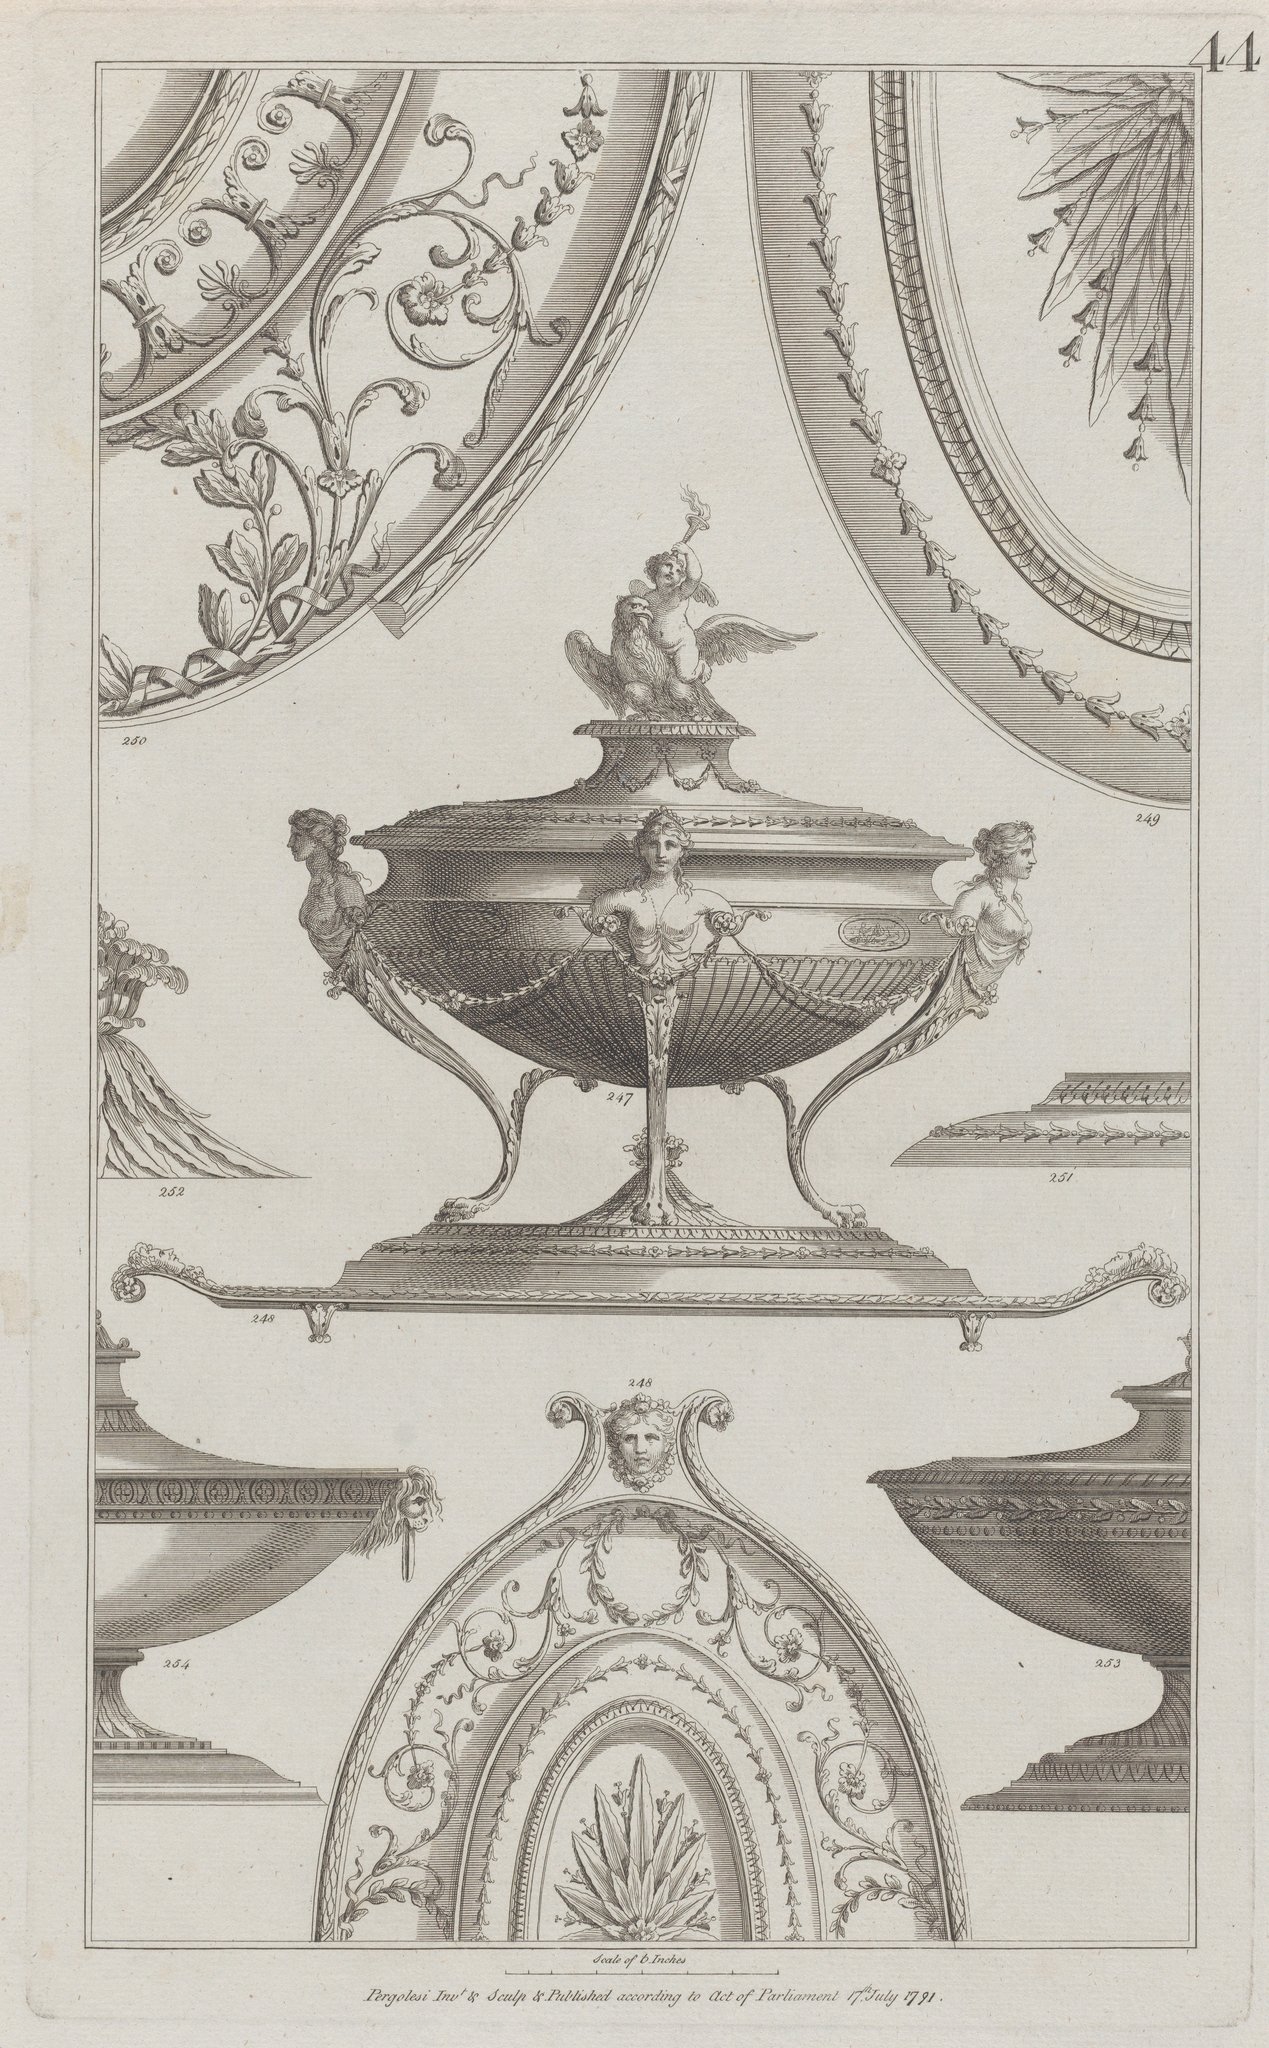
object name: print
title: Vases and Vessels, nos. 248–254, plate 44 from "Designs for Various Ornaments"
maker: michelangelo pergolesi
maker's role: artist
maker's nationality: italian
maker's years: 1760-1801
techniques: engraving, etching